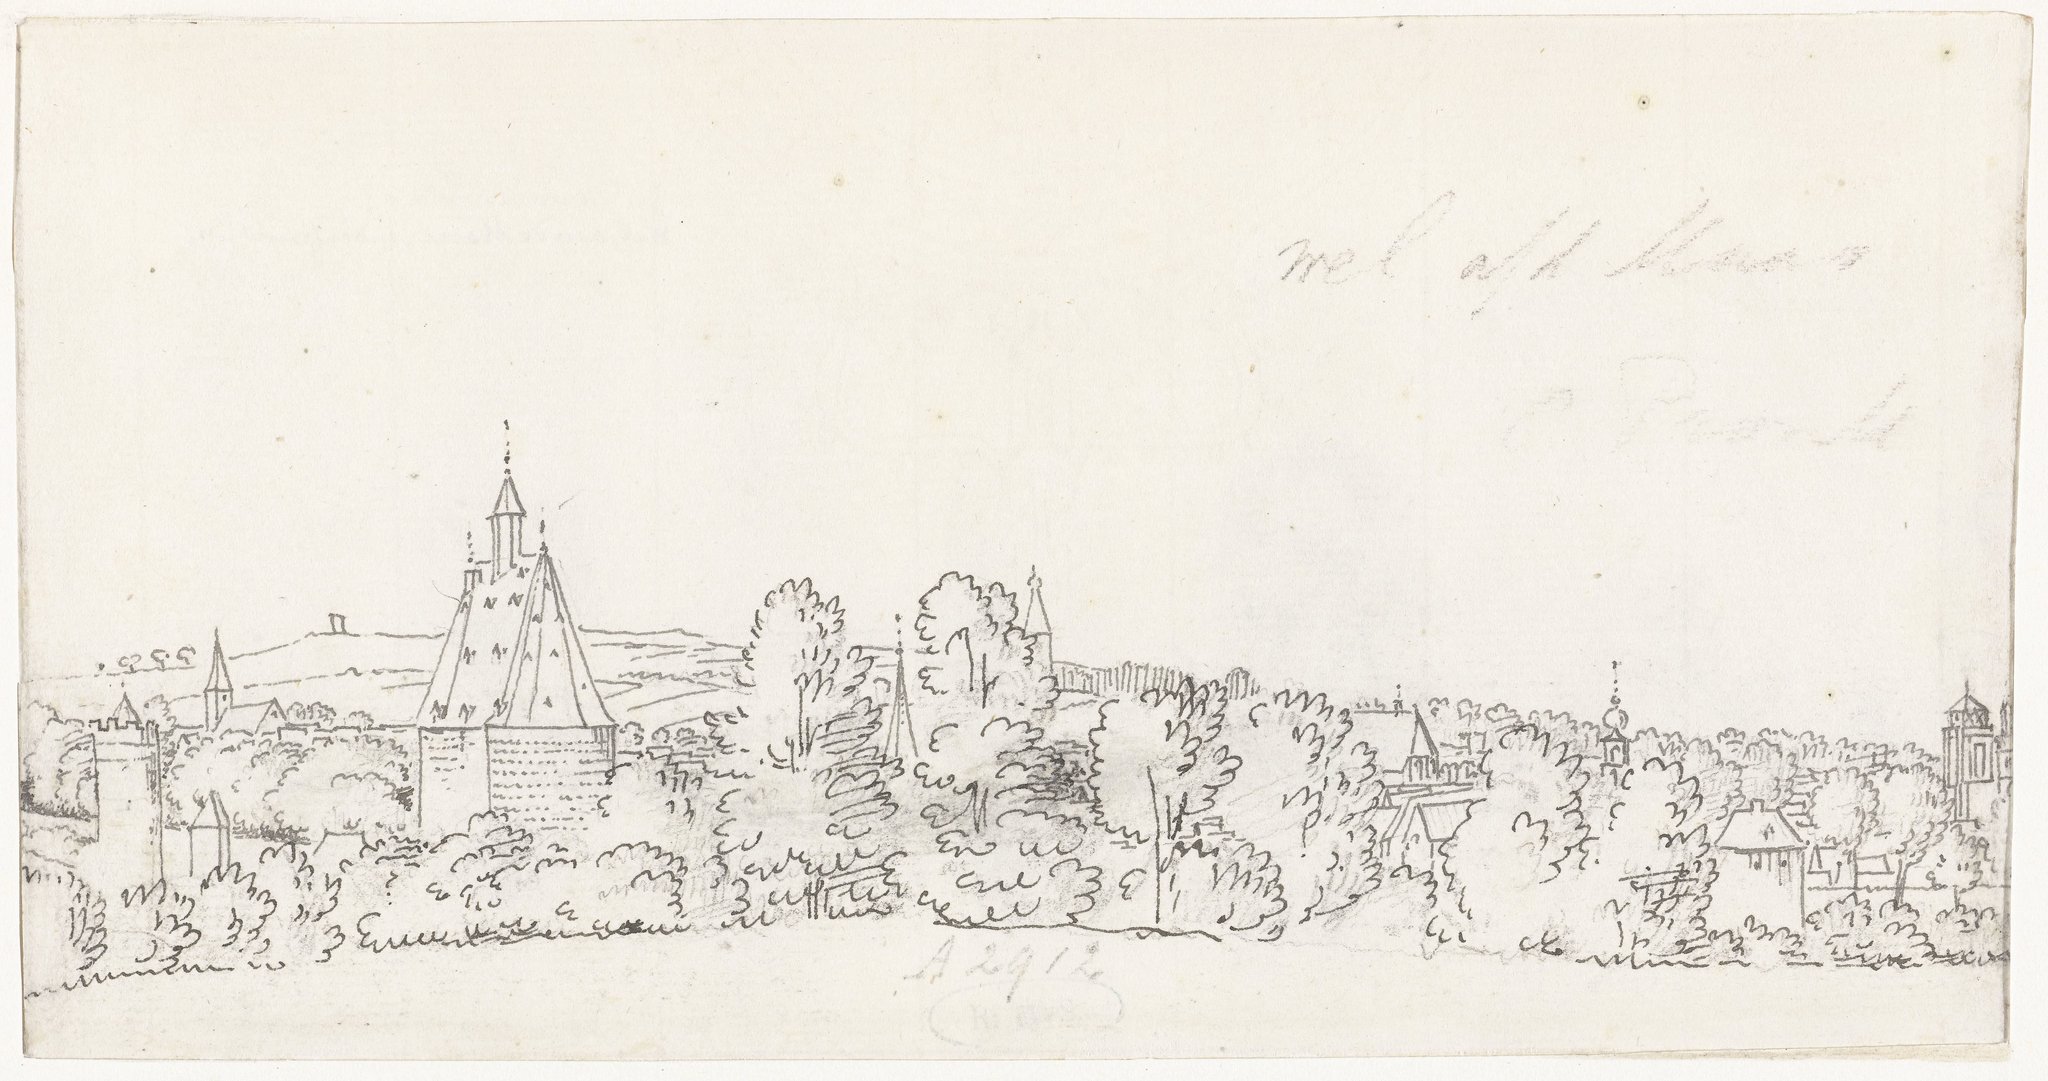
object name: drawing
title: Gezicht op Well, aan de Maas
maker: cornelis pronk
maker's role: draughtsman, painter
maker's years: 1691-1759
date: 1701-1759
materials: ink, paper, pencil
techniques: pen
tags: village